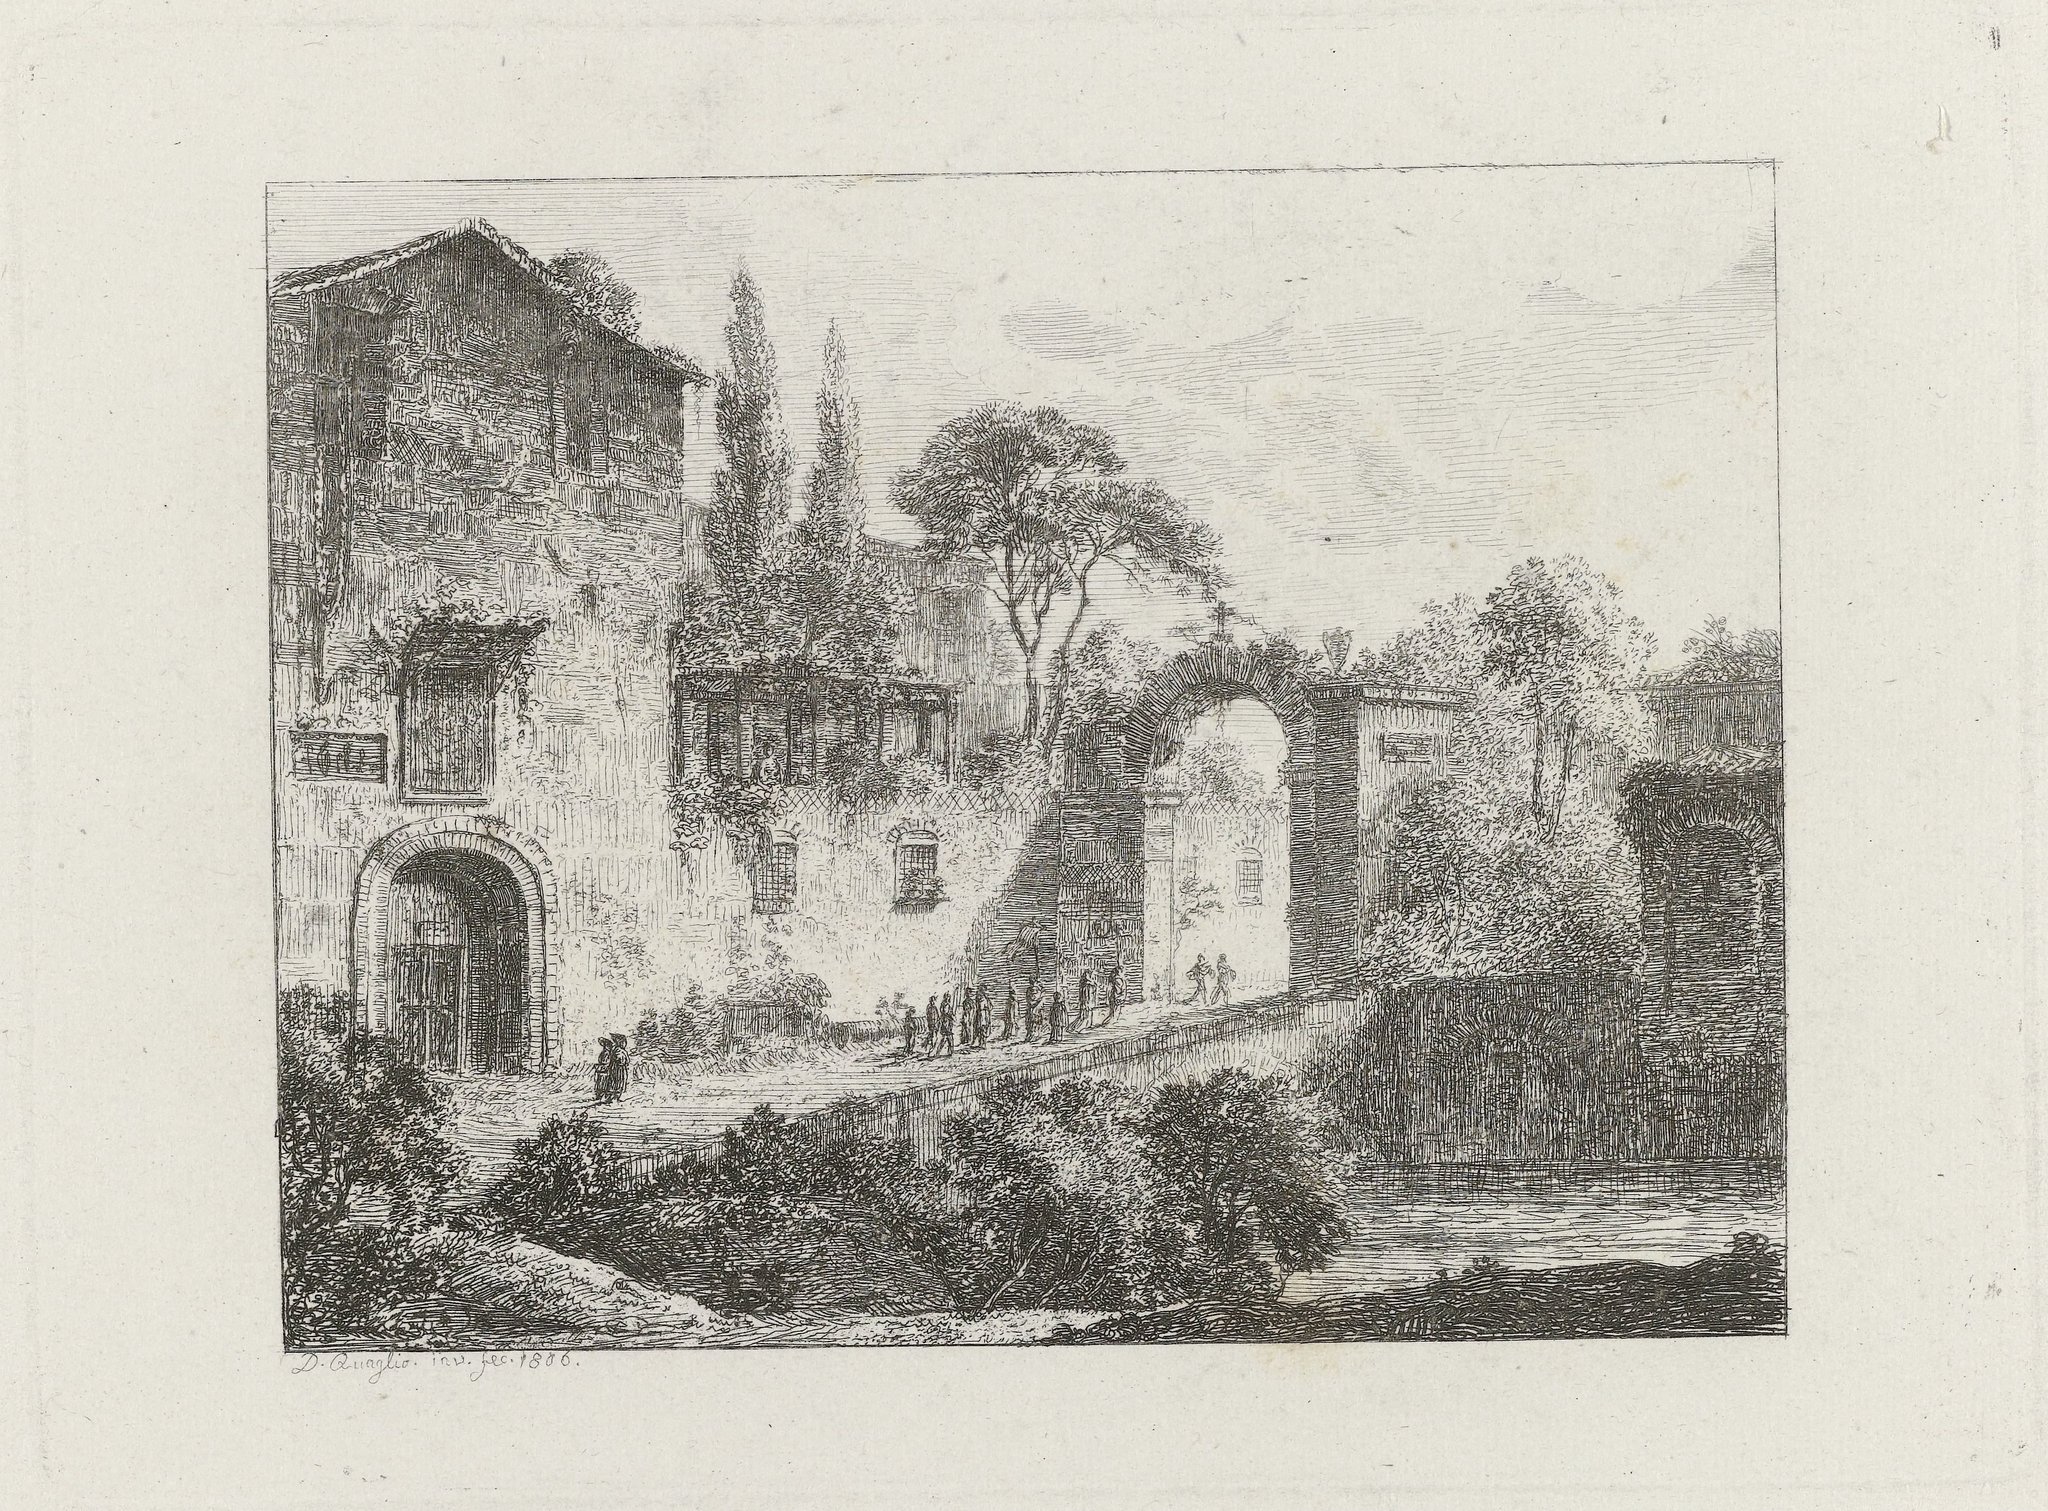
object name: print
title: Vier und Zwanzig Landschaftliche Gegenstände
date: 1806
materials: paper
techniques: etching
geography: karlsruhe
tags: village-gate (+ city(-scape) with figures, staffage)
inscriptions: collector's mark: Lugt 2228, collector's mark: Lugt 2760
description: Deze prent maakt deel uit van een serie van 24 prenten.